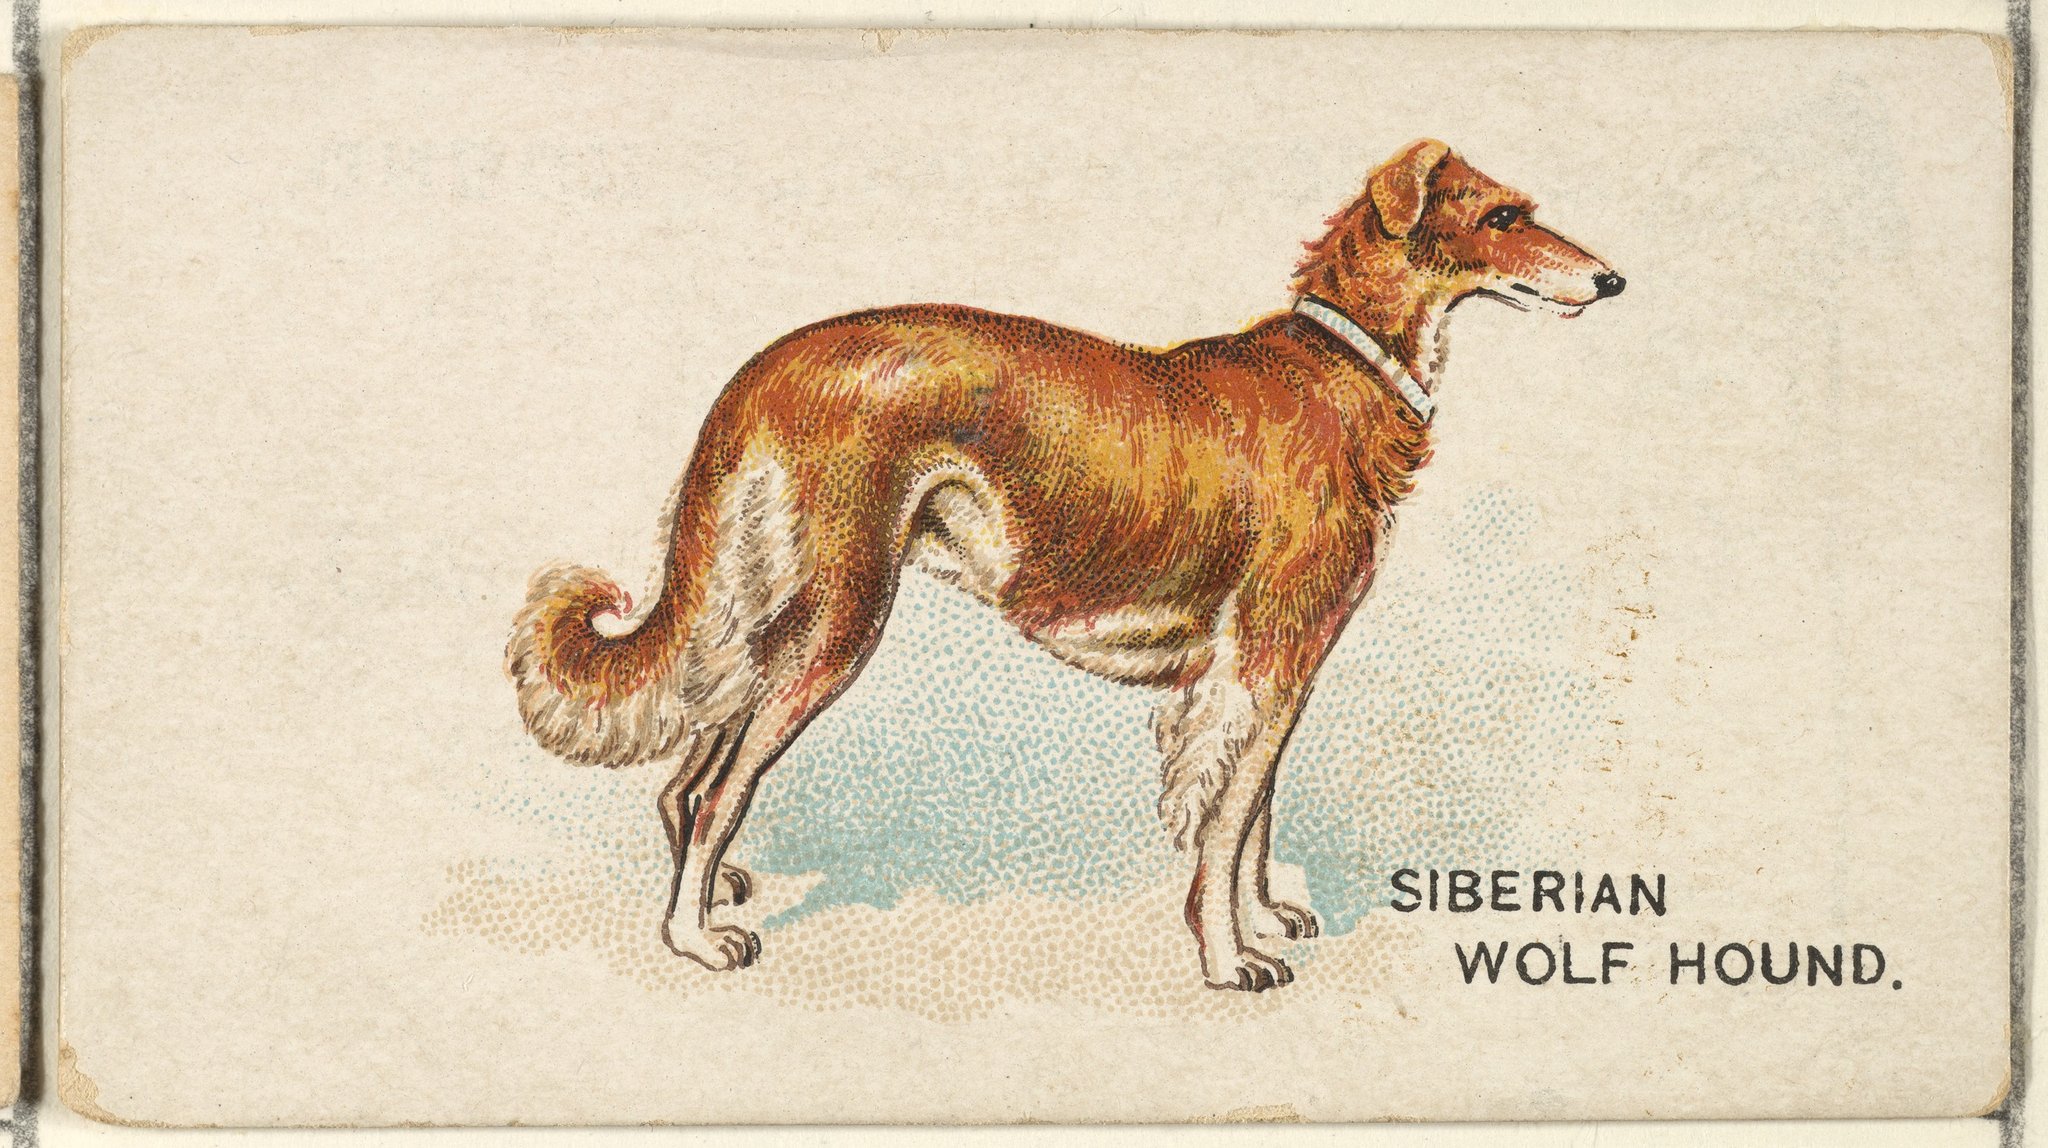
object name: print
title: Siberian Wolf Hound, from the Dogs of the World series for Old Judge Cigarettes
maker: goodwin & company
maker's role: publisher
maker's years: 1850-1950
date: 1890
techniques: color lithograph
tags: dogs